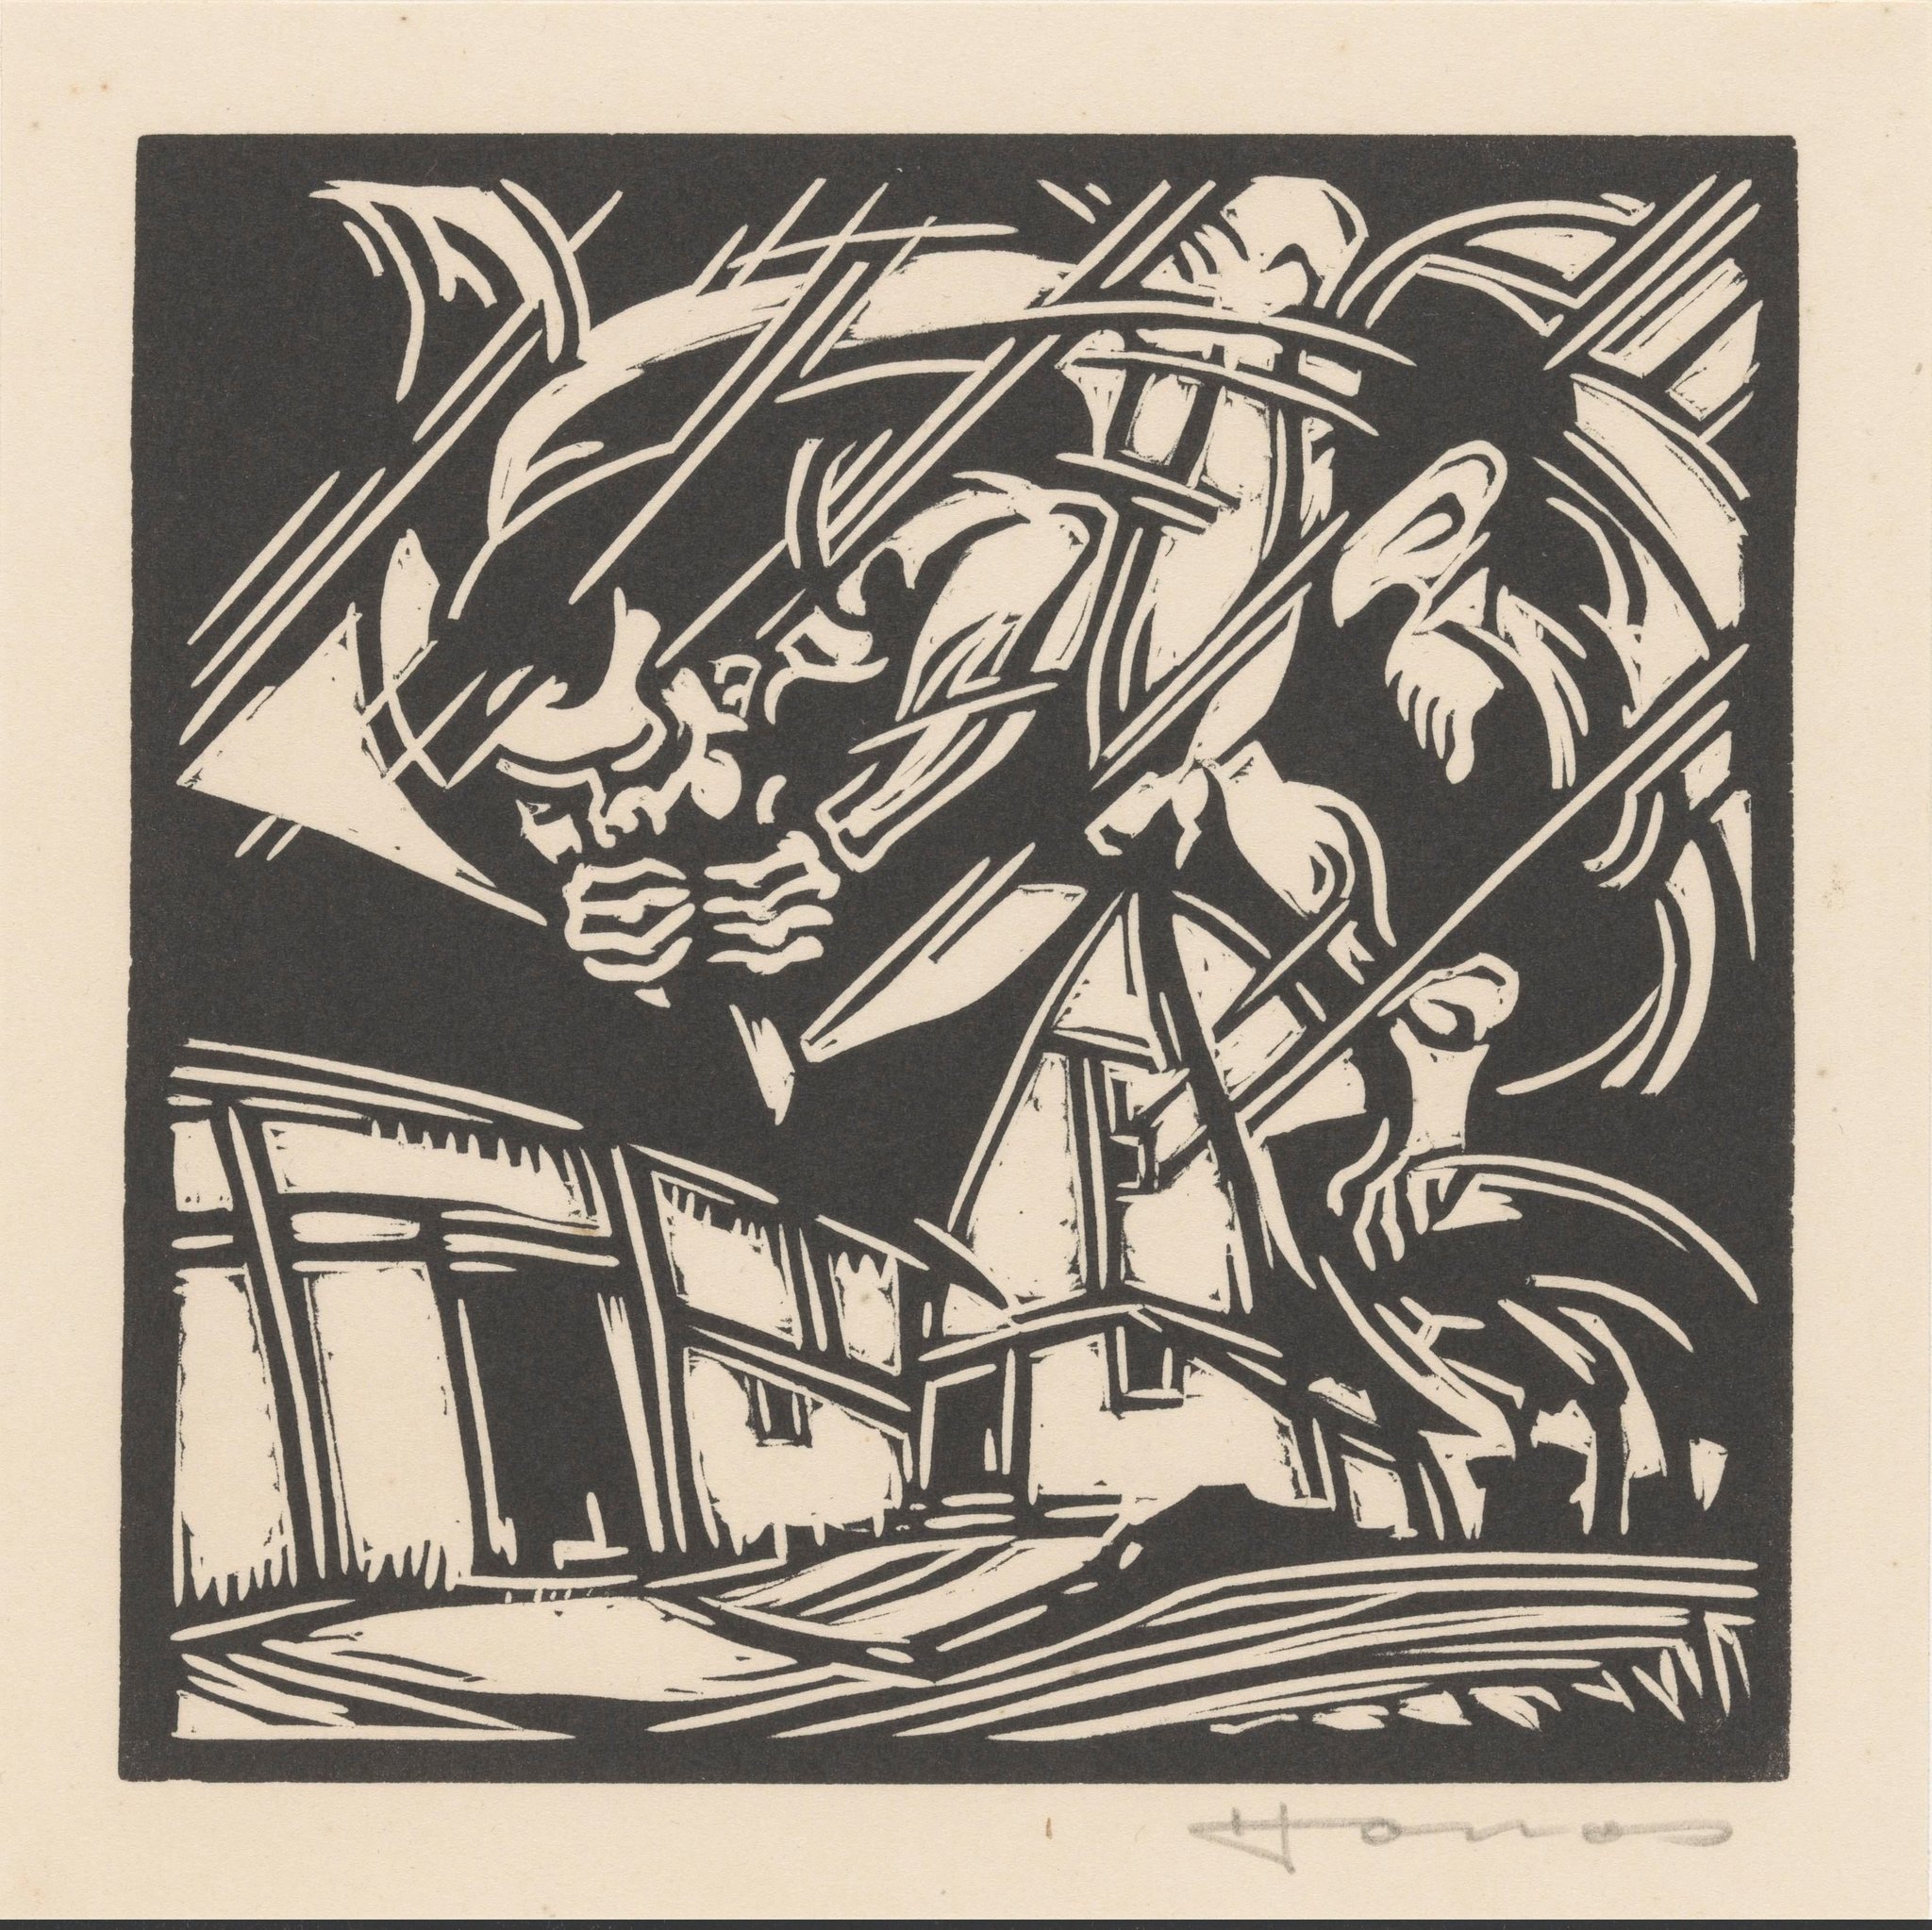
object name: print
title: Personificatie van de wind bij een gebouw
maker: henri jonas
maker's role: draughtsman, print maker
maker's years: 1878-1944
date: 1921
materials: paper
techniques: woodcut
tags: winds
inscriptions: collector's mark: Lugt 2228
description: Prent gebruikt voor: Kemp, Mathias. De zeven broeders. Maastricht: Leiter-Nypels, 1921.